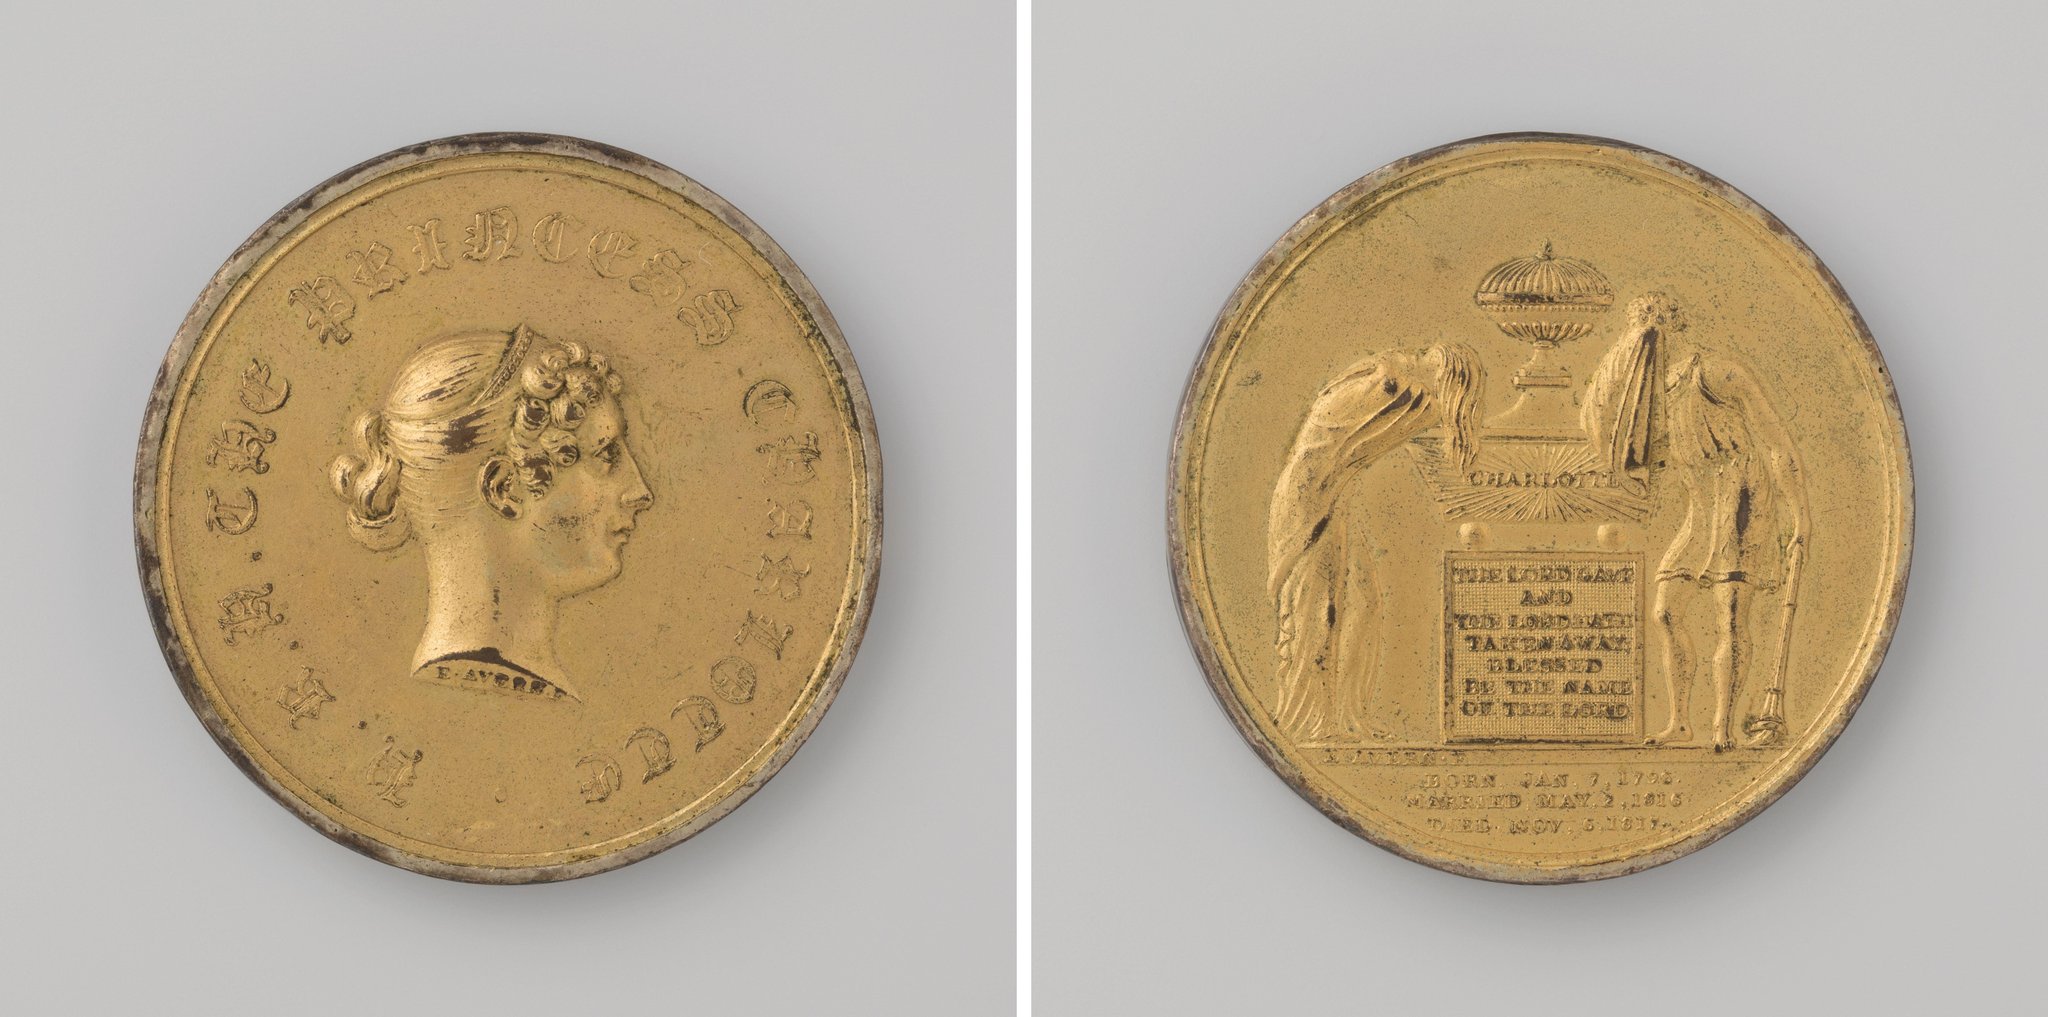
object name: history medal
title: Overlijden van Charlotte Augusta, prinses van Engeland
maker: edward avern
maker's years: 1817-1844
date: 1817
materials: silver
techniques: gilding, striking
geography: england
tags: london, charlotte augusta (prinses van wales)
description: Zilveren penning. Voorzijde: borststuk vrouw met diadeem binnen omschrift in Gothische letters. Keerzijde: man met omgekeerde fakkel en vrouw treurend bij graftombe met opschrift; afsnede: opschrift